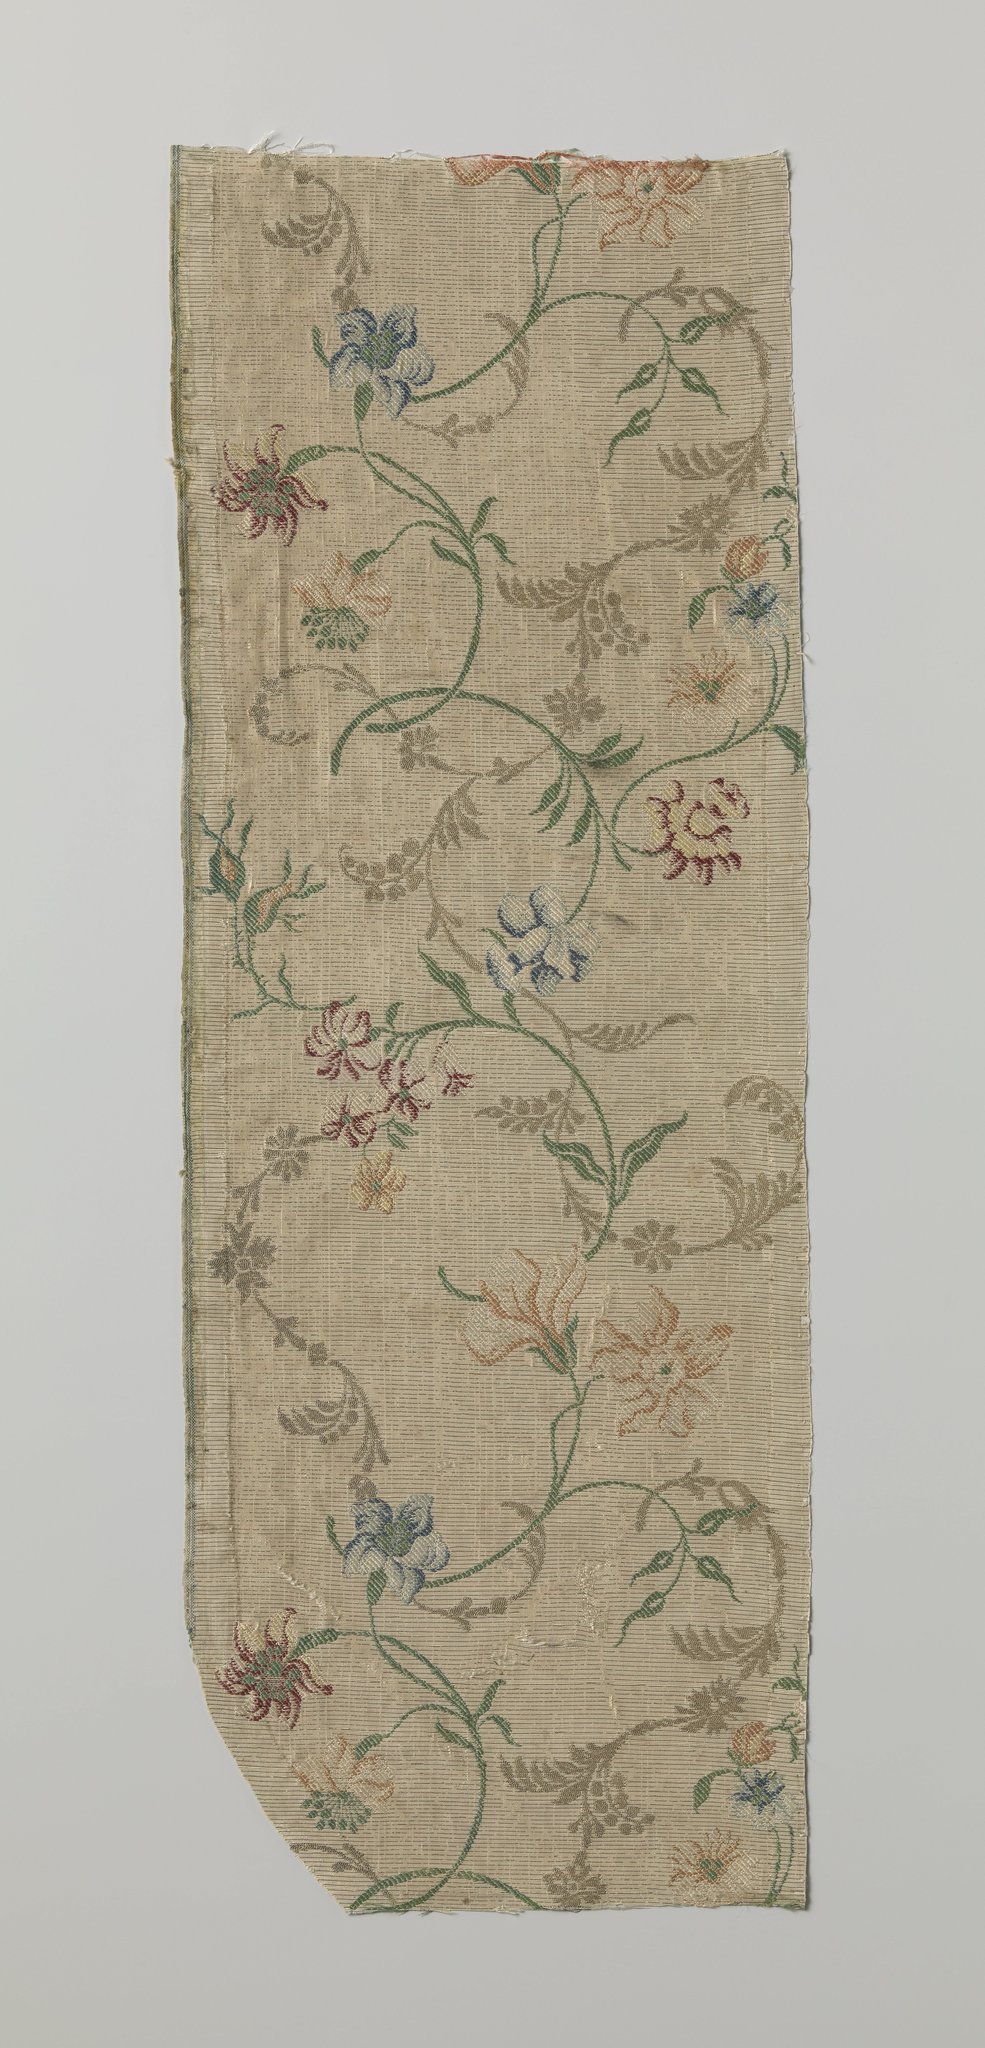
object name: fragment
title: Fragment veelkleurige gebrocheerde zijde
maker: Anonymous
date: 1740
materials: silk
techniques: brocade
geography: england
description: Een zijdeweefsel, bestaande uit twee rechthoekige lappen, groene ranken met diverse bloemen o.a. grote zalmkleurige kelkvormige blauwe, rode en witte rozet bloemen. Opmerking: Twee panelen aan elkaar gezet links en rechts een zelfkant; 0.3 cm effenbinding.